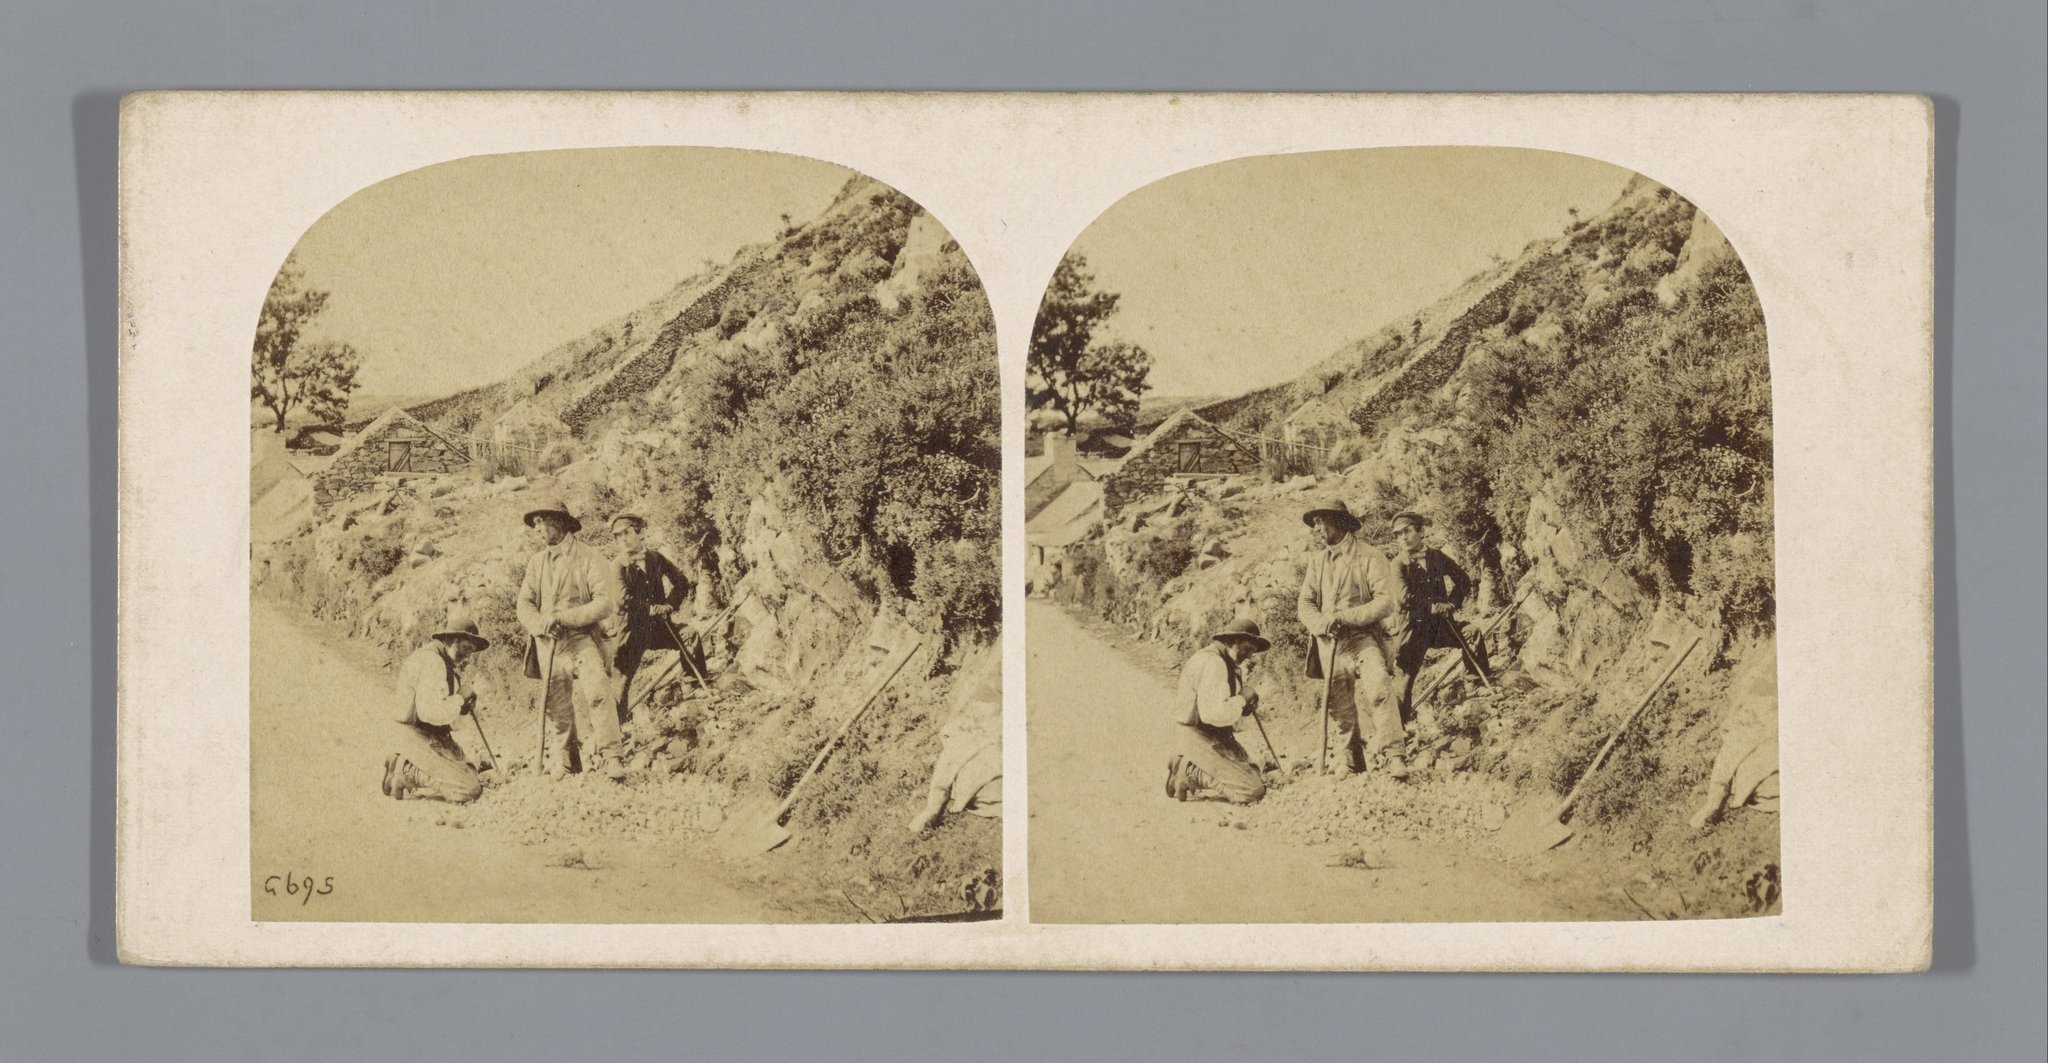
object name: stereograph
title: Drie steenhakkers op een landweg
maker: william morris grundy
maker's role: fotograaf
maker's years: 1806-1859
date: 1850-1880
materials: cardboard, photographic support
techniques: albumen print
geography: groningen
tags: stone-cutter, stone-sawyer, europe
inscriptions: name: ‘[...]dbrugge & co oningen’, number: ‘120’, inscription: ‘[...] 112040’, number: ‘G 695’